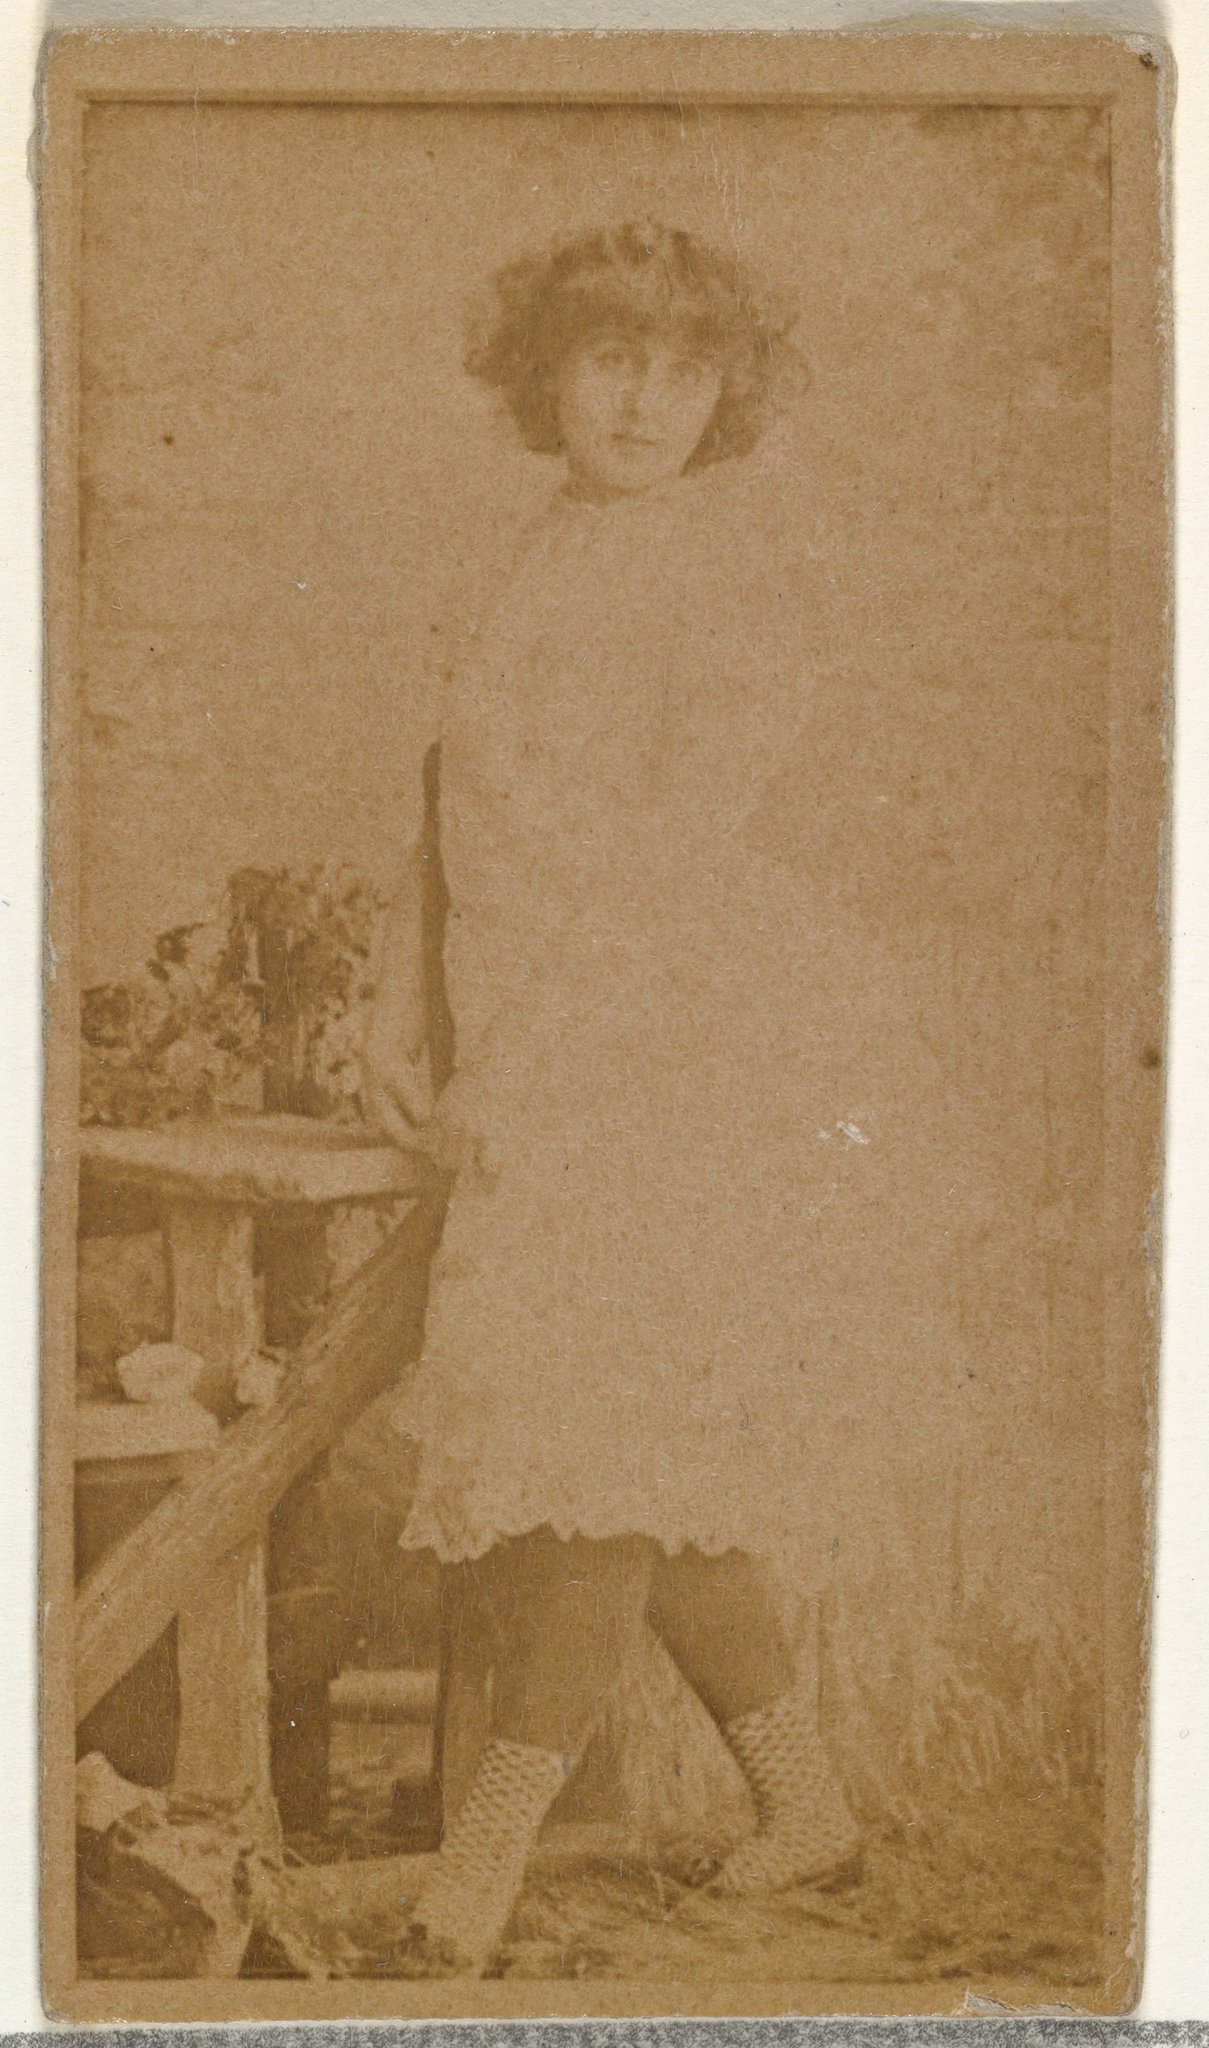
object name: photograph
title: [Actress posing by prop wooden fence], from the Actors and Actresses series (N145-8) issued by Duke Sons & Co. to promote Duke Cigarettes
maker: w. duke, sons & co.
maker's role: publisher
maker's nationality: american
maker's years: 1870-1920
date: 1891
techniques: albumen silver print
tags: portraits,women,actresses